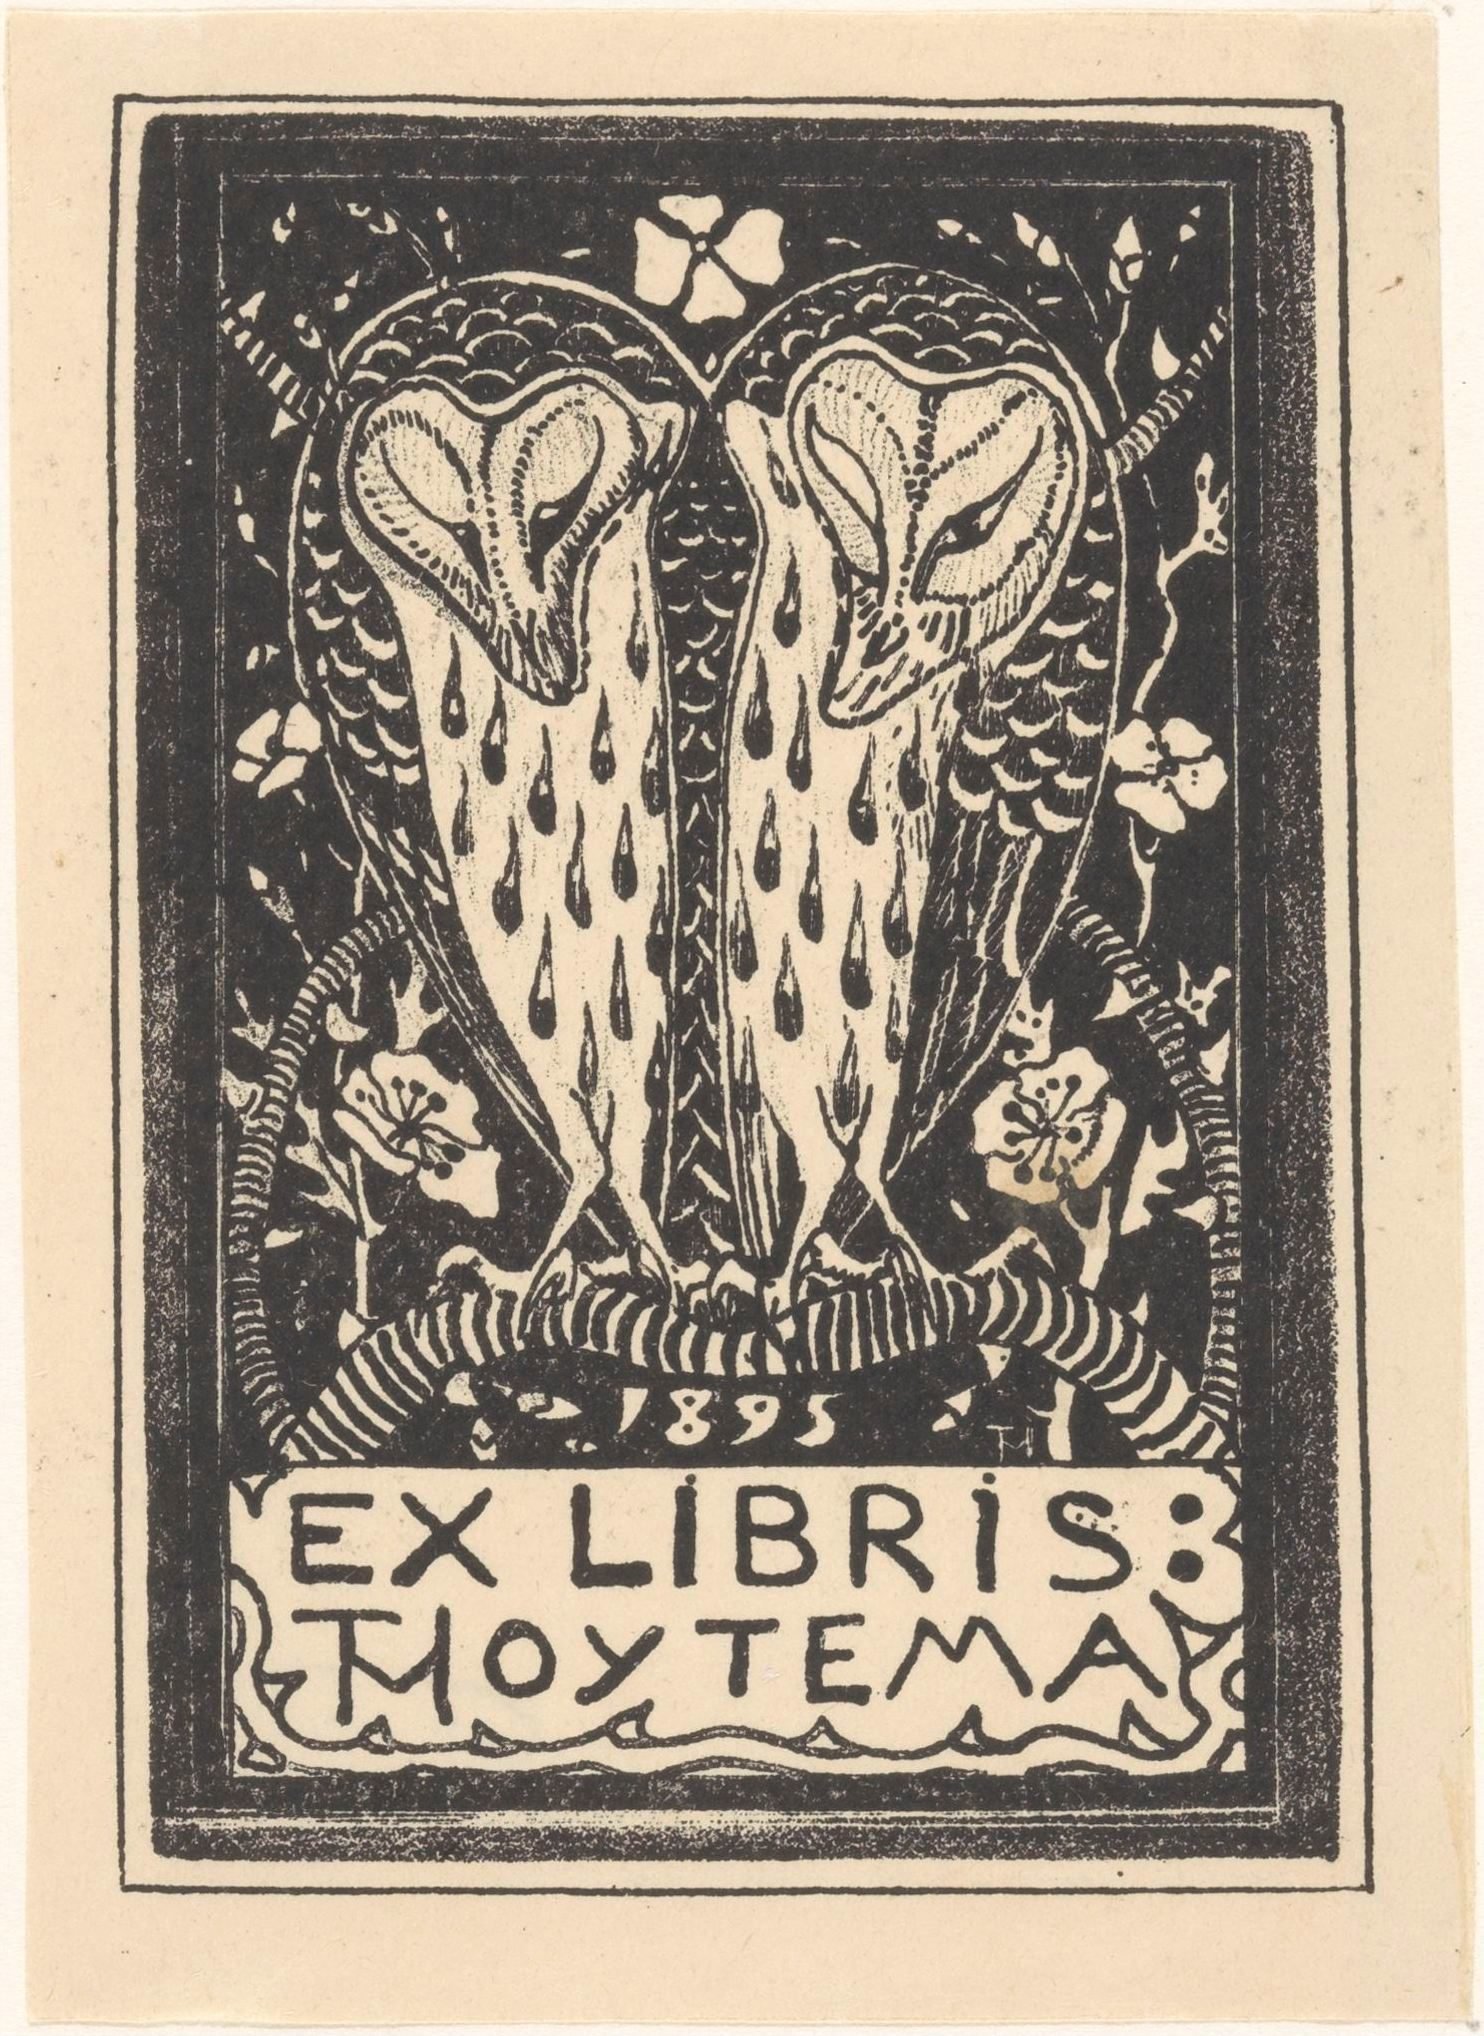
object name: print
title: Ex libris van Theo van Hoytema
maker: theo van hoytema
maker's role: draughtsman, painter, print maker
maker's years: 1863-1917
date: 1895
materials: paper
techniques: lithograph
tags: the hague, painter, print maker, draughtsman, theo van hoytema, owls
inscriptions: collector's mark: Lugt 2228